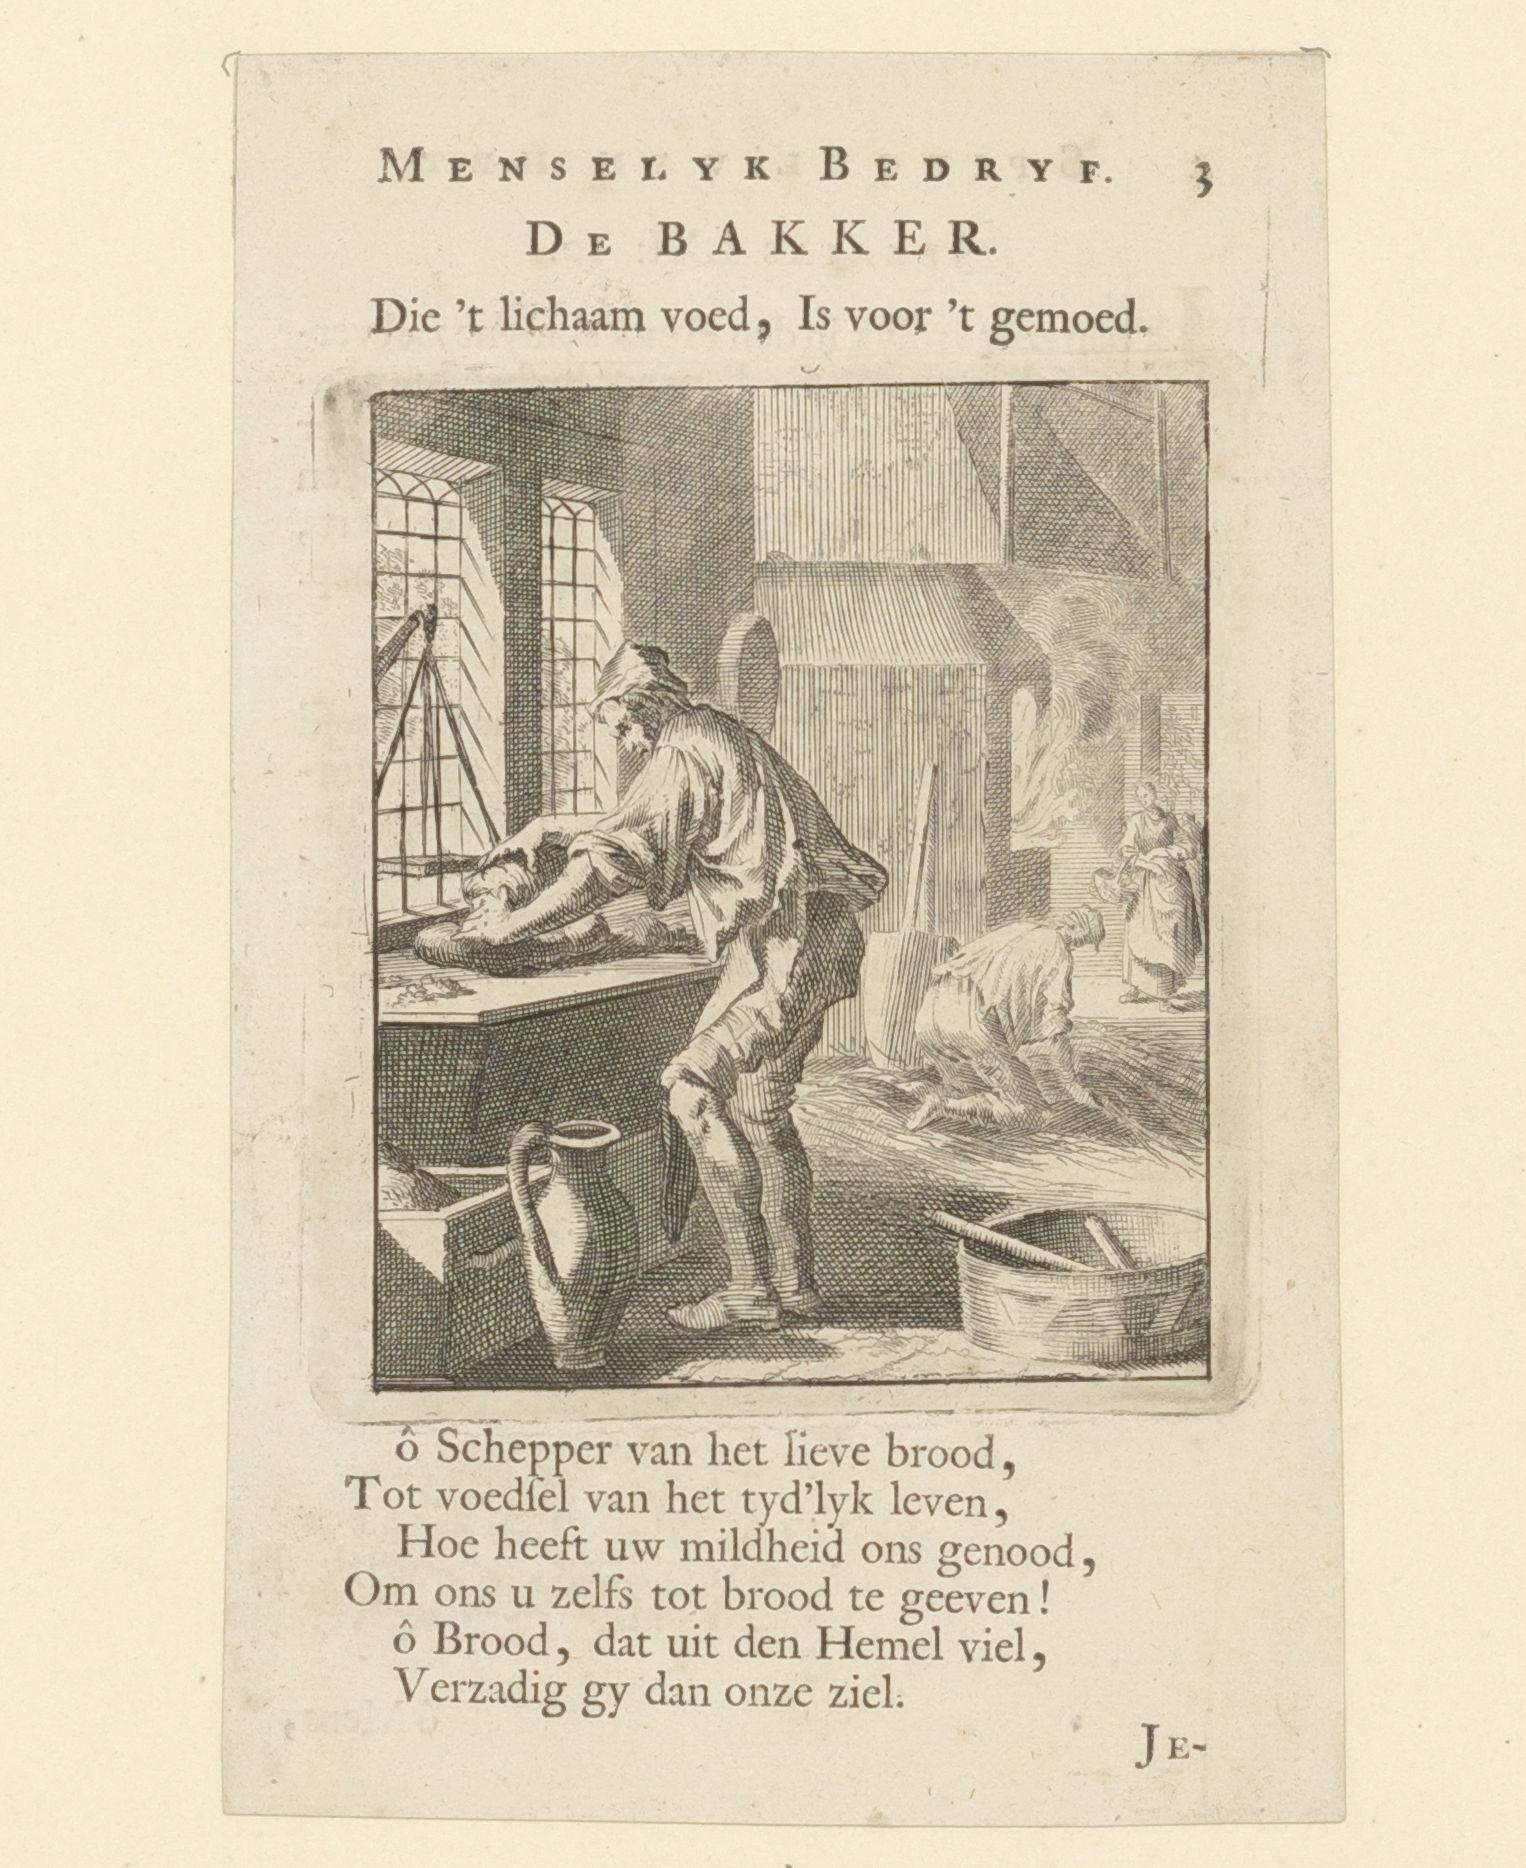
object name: print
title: De Bakker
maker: cornelis van der sys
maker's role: publisher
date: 1718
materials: paper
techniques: etching, letterpress printing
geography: amsterdam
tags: handicrafts, craftsman at work, baker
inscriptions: collector's mark: Lugt 1641, stamp, stamp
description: Prent oorspronkelijk verschenen in de 100-delige serie beroepsprenten van Jan en Caspar Luyken, getiteld: Het menselyk bedryf. S.l.s.n., 1694 (eerste druk). Daarna is de titel en het vers afgesneden. De prenten in diverse publicaties verschenen en gekopieerd. Huidige staat uit: Luyken, Jan en Caspar. Spiegel van het menselyk bedryf (...). Amsterdam: Cornelis van der Sys, 1718. Prent waarschijnlijk ook gebruikt in eerdere (1704) en latere (1730, 1749, 1767) publicaties.